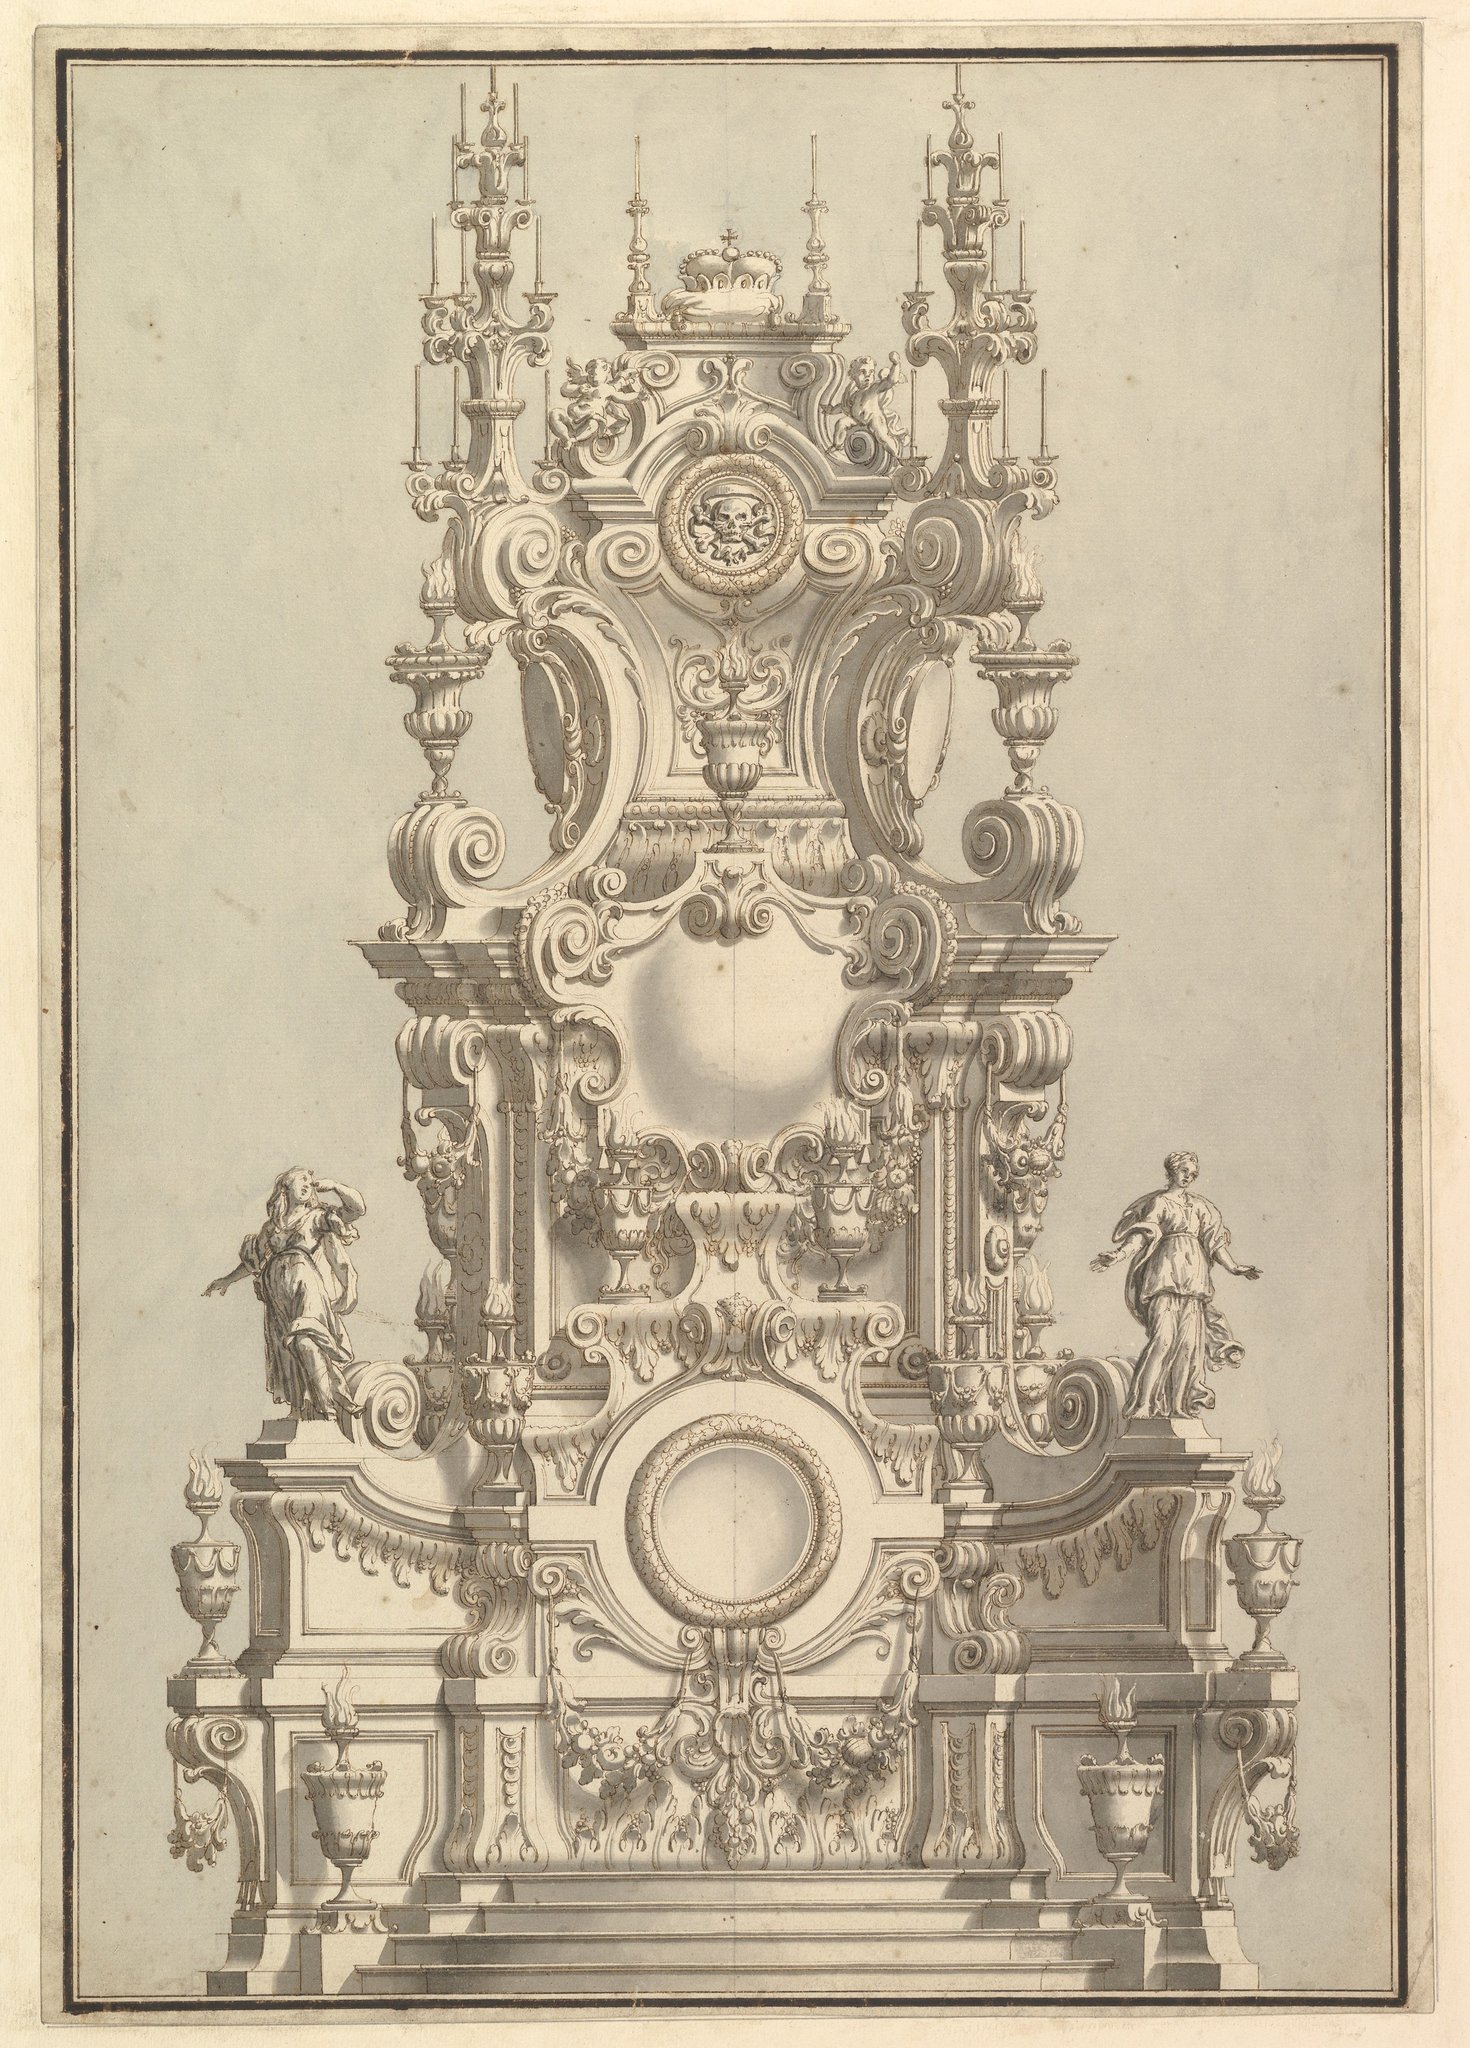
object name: drawing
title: Elevation of a Catafalque, Surmounted by a Royal Crown, with Scull and Cross Bones in Wreath-Encircled Cartouche just below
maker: giuseppe galli bibiena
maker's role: artist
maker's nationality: italian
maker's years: 1696-1756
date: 1696-1756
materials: ink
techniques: pen, wash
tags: human figures,architecture